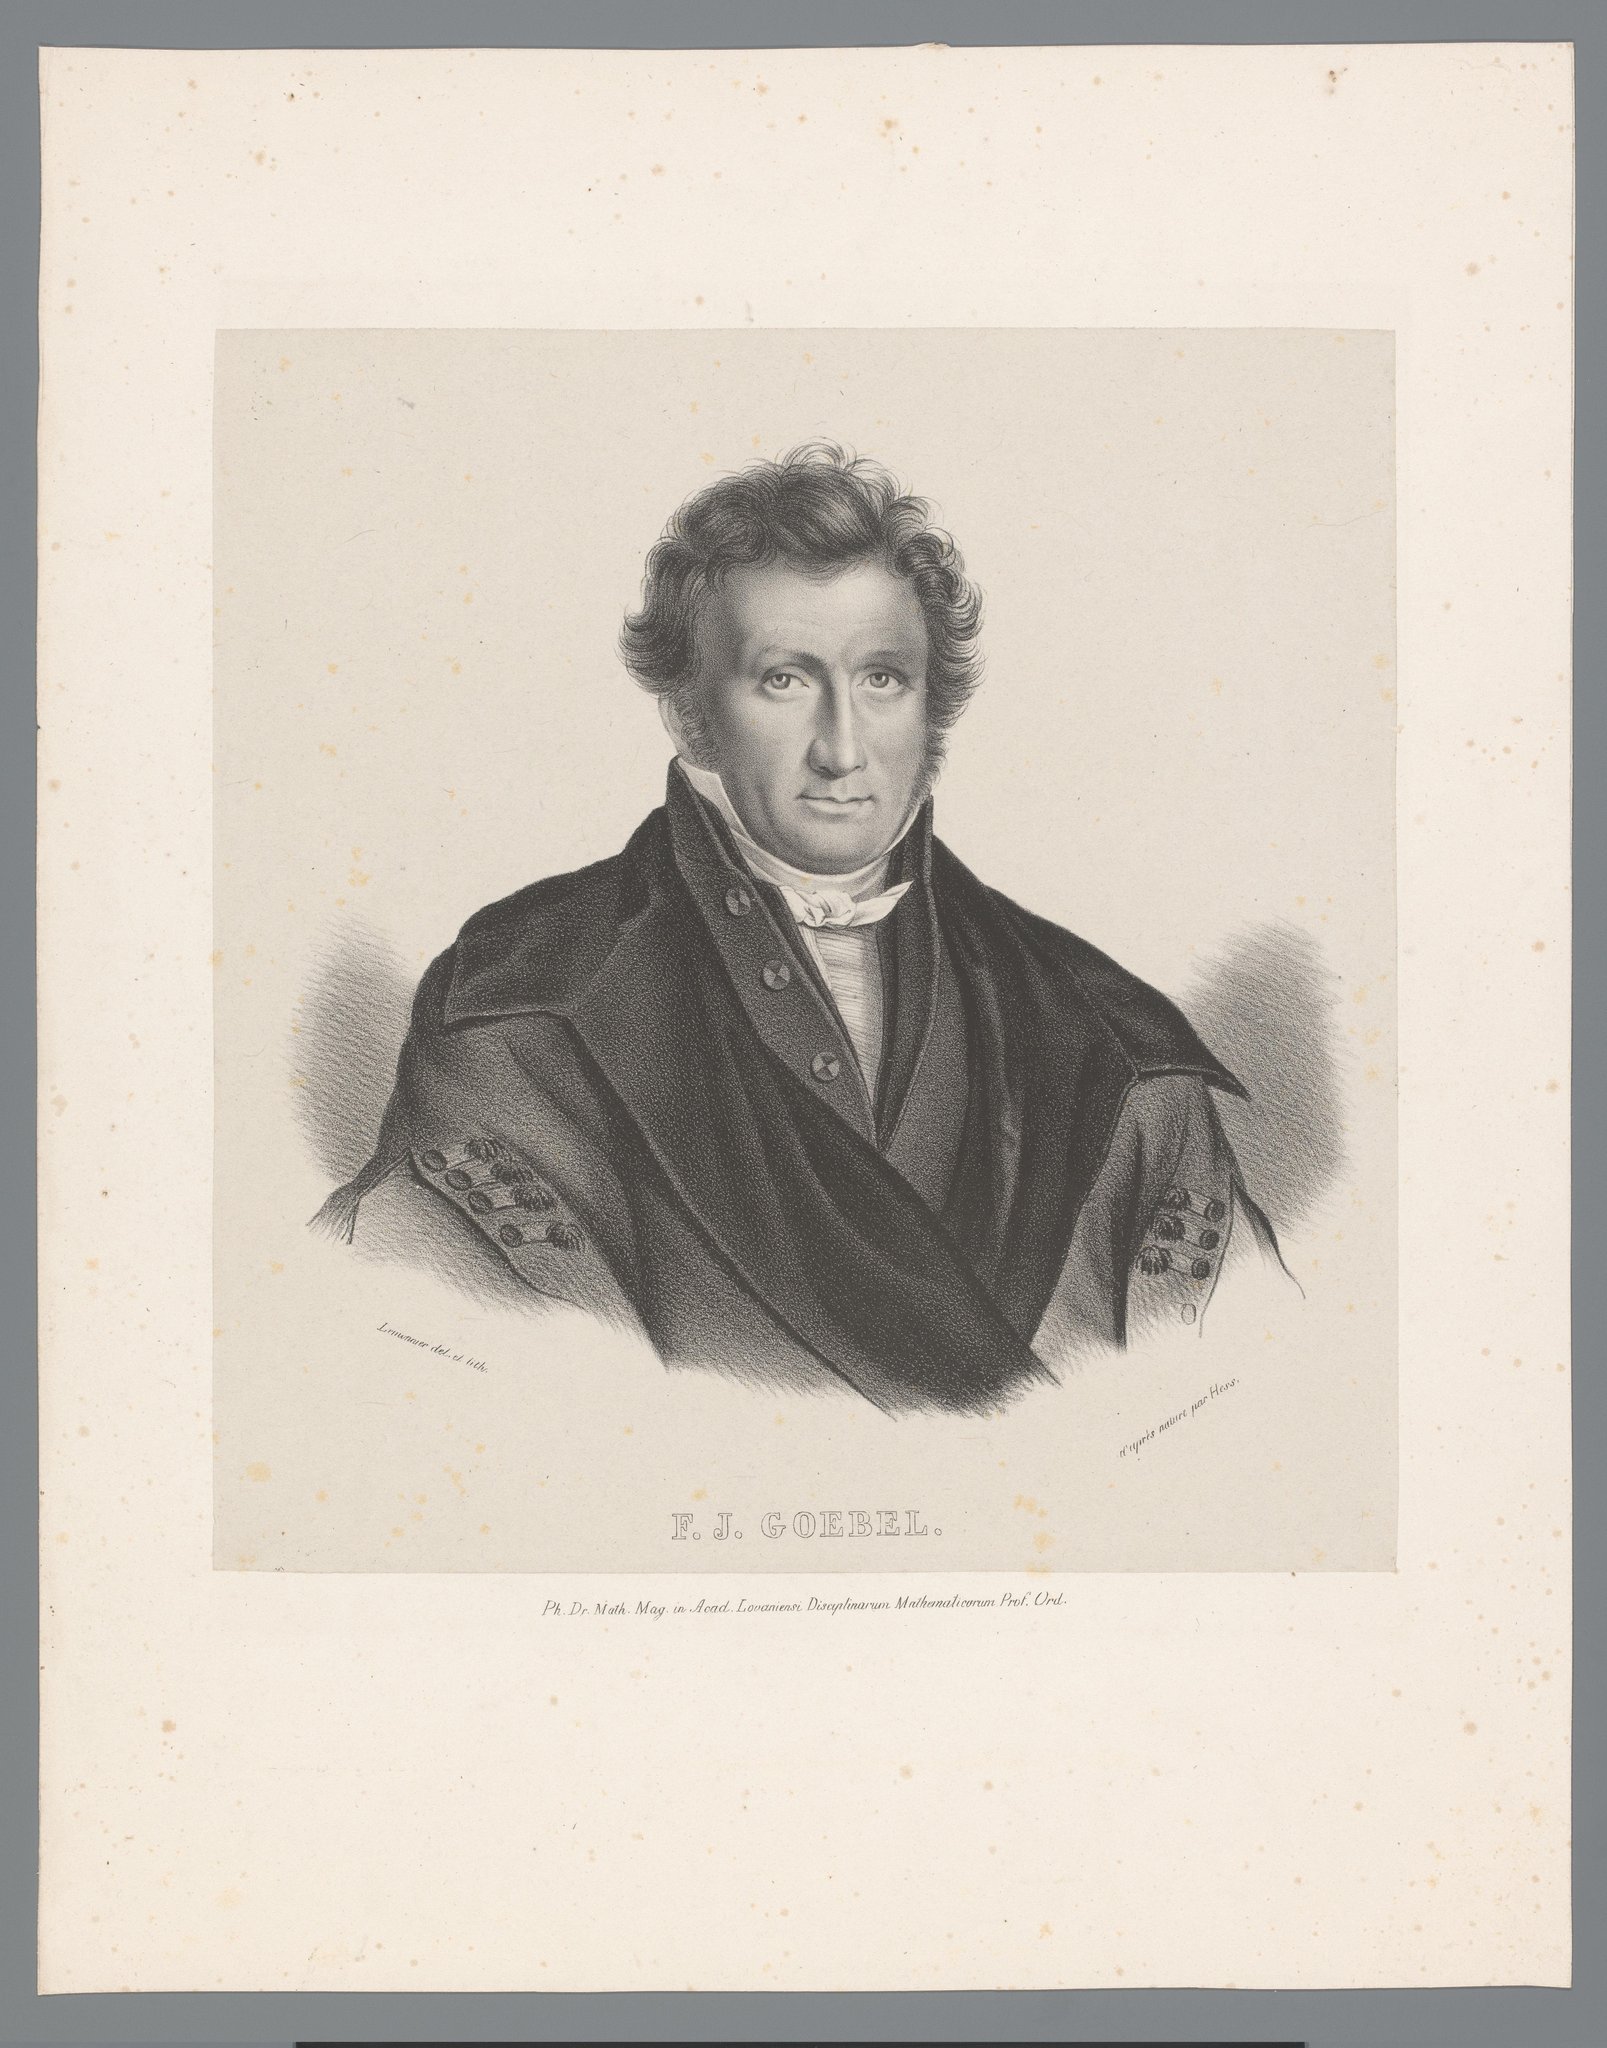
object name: print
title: Portret van F.J. Goebel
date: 1823-1841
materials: paper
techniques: lithograph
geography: brussels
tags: adult man, historical persons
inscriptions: collector's mark: Lugt 2228